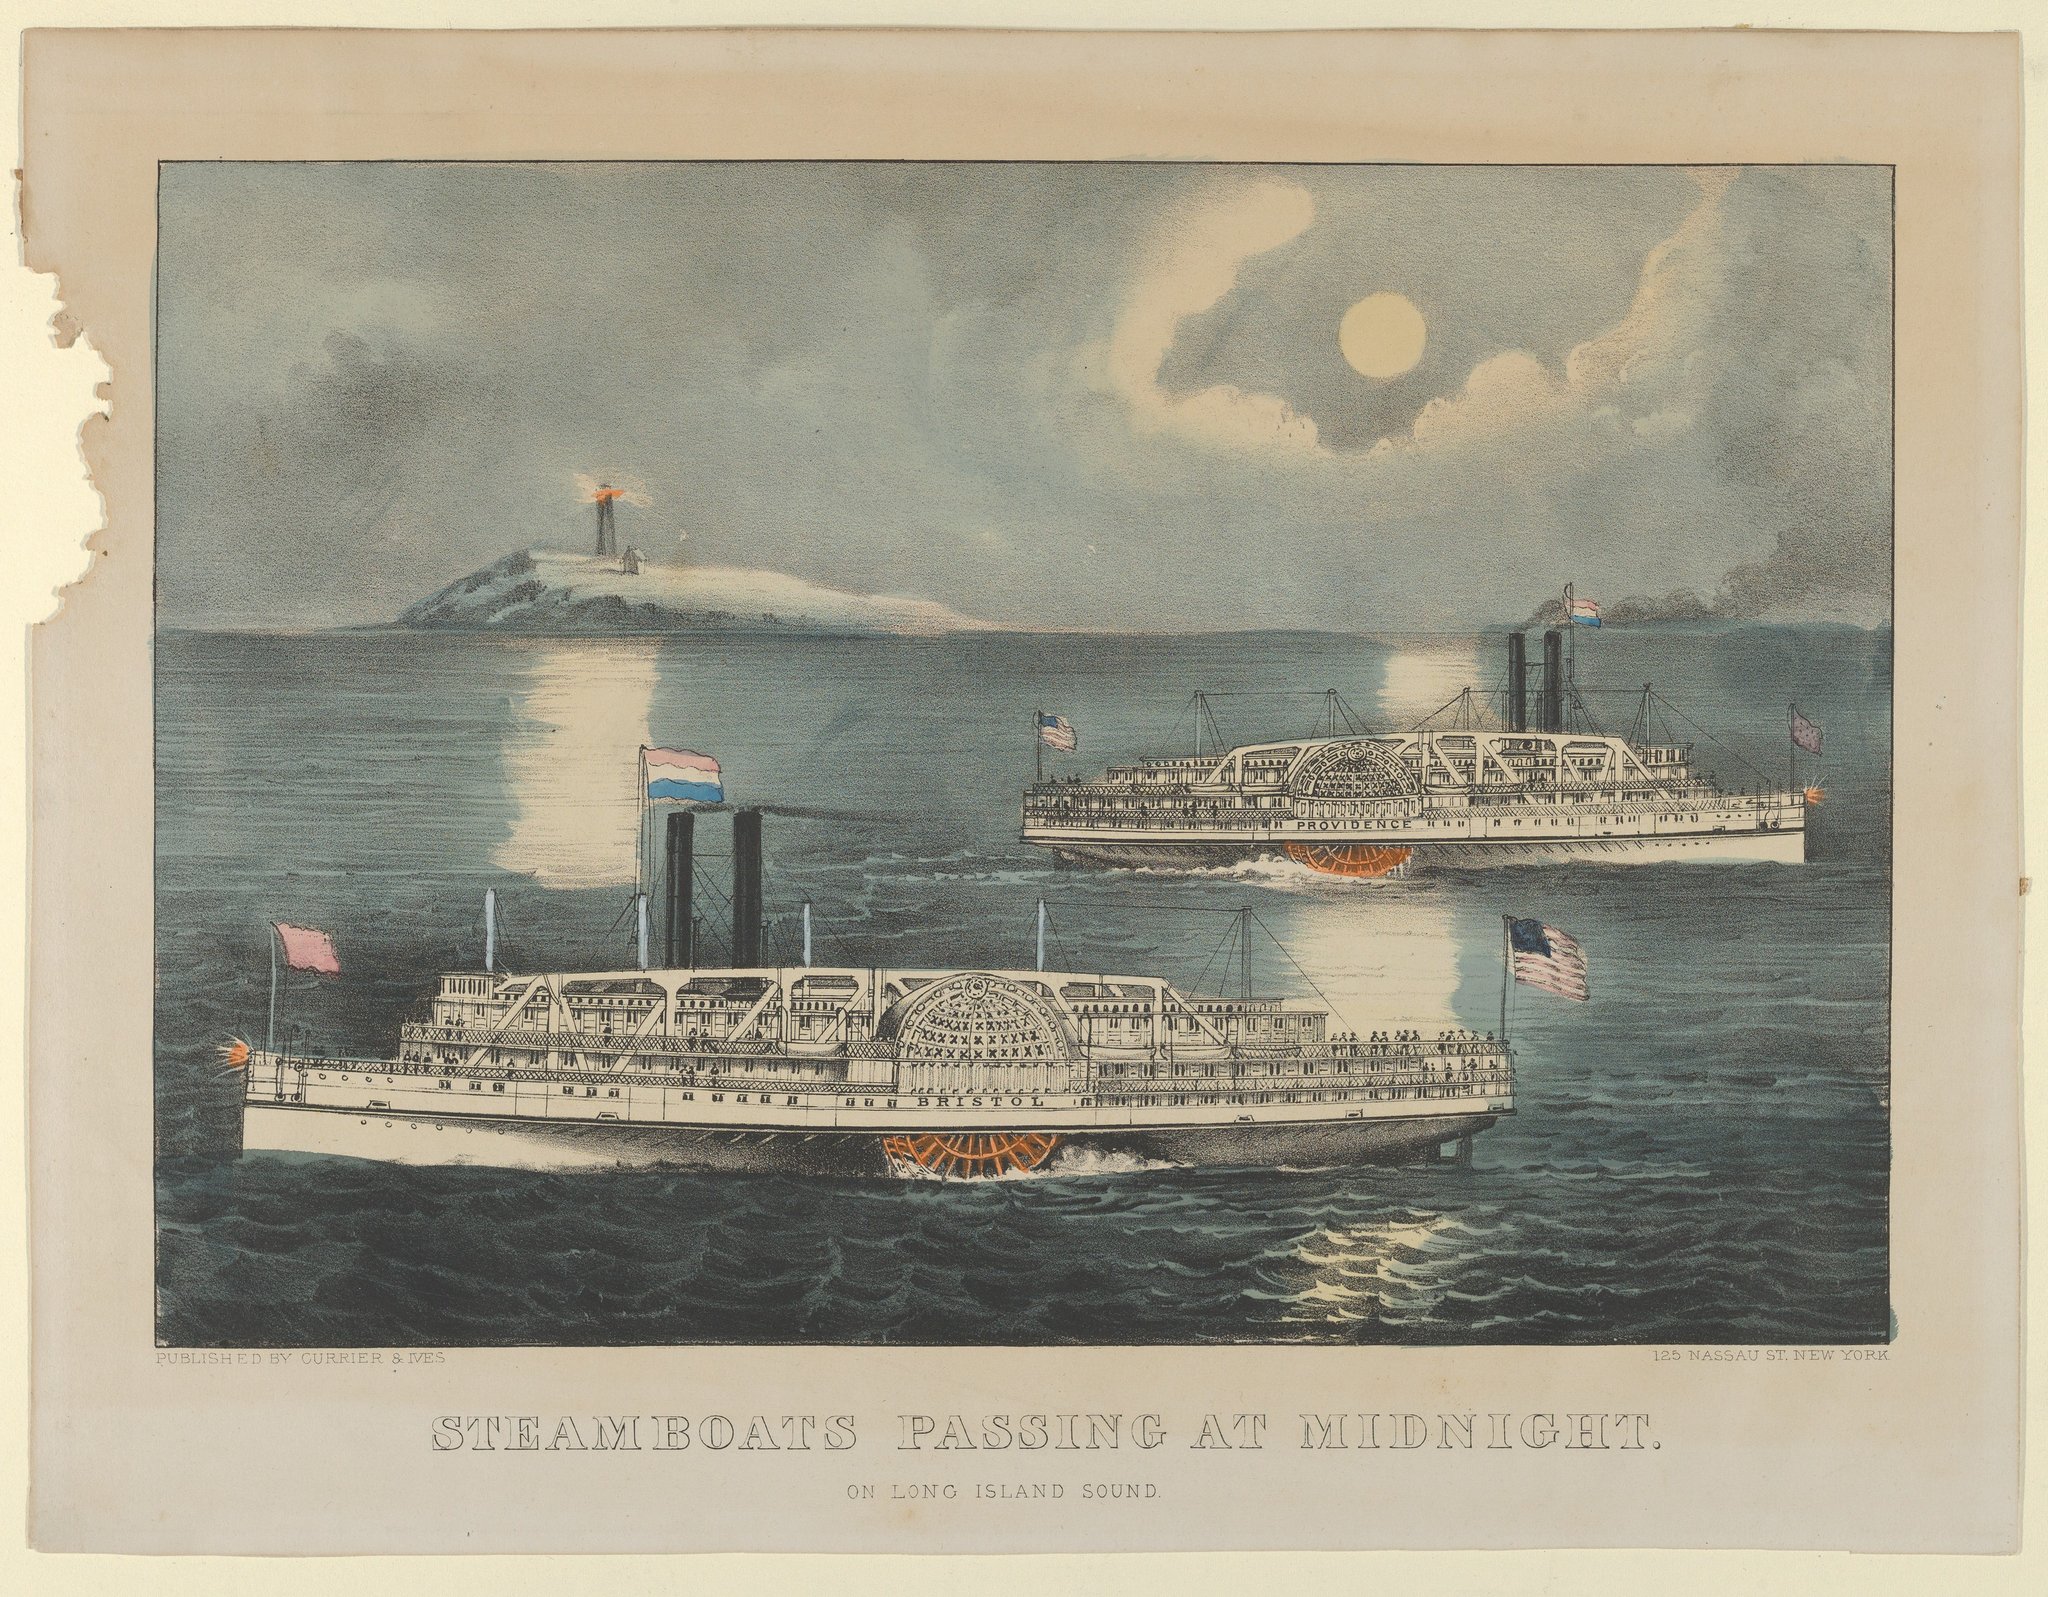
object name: print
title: Steamboats Passing at Midnight – On Long Island Sound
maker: currier & ives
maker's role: lithographer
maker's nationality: american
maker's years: 1857-1907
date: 1868-1878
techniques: hand coloring, lithograph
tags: boats